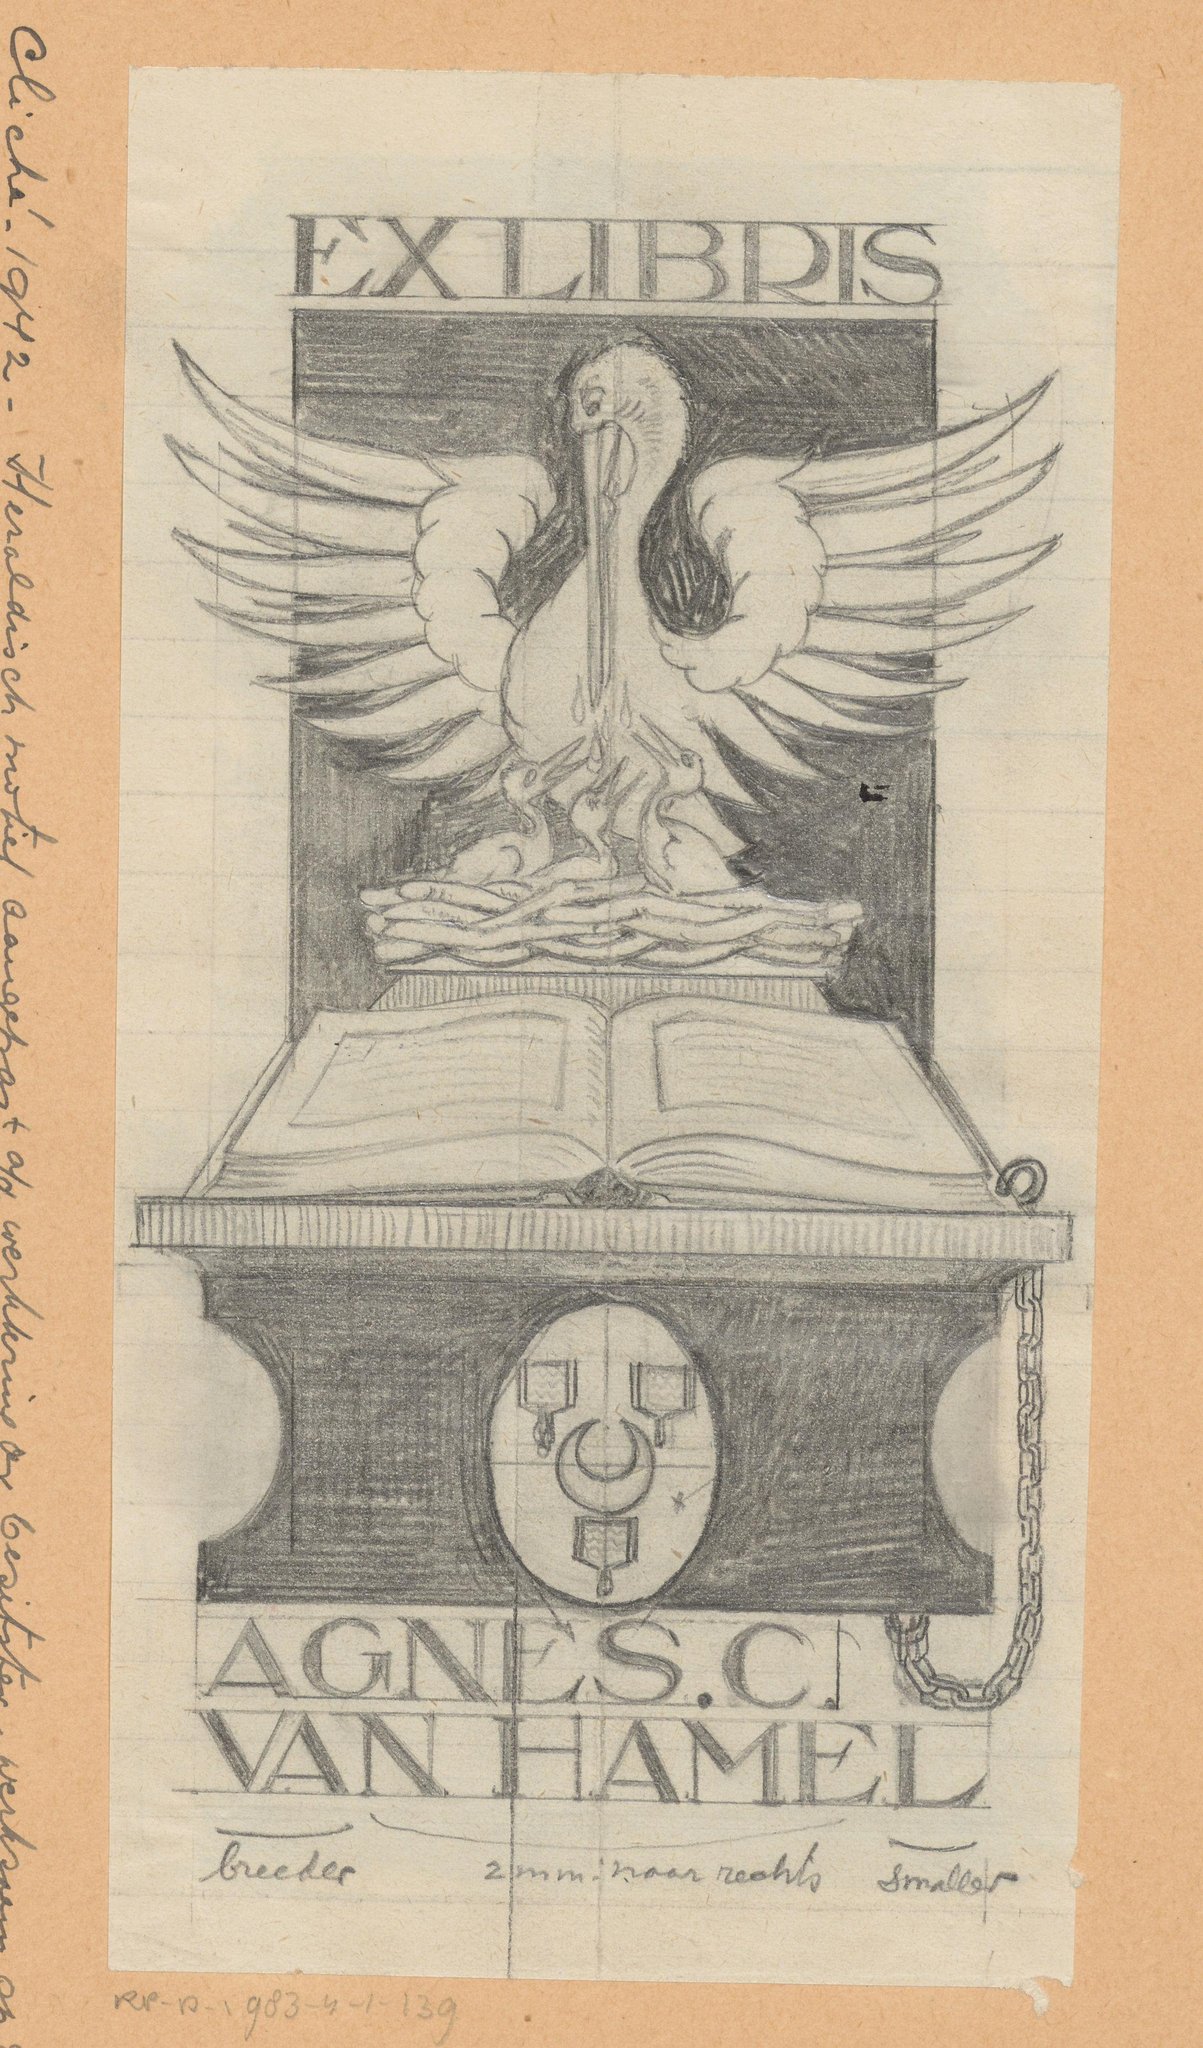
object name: bookplate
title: Ontwerptekening voor ex libris van Agnes C. van Hamel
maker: otto verhagen (i)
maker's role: draughtsman, print maker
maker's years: 1885-1951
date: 1942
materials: paper, pencil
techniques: drawing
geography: netherlands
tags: symbols of christ ~ animals, book, armorial bearing, heraldry, water-birds: pelican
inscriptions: inscription: ‘breeder/ 2 mm naar rechts/ smaller’